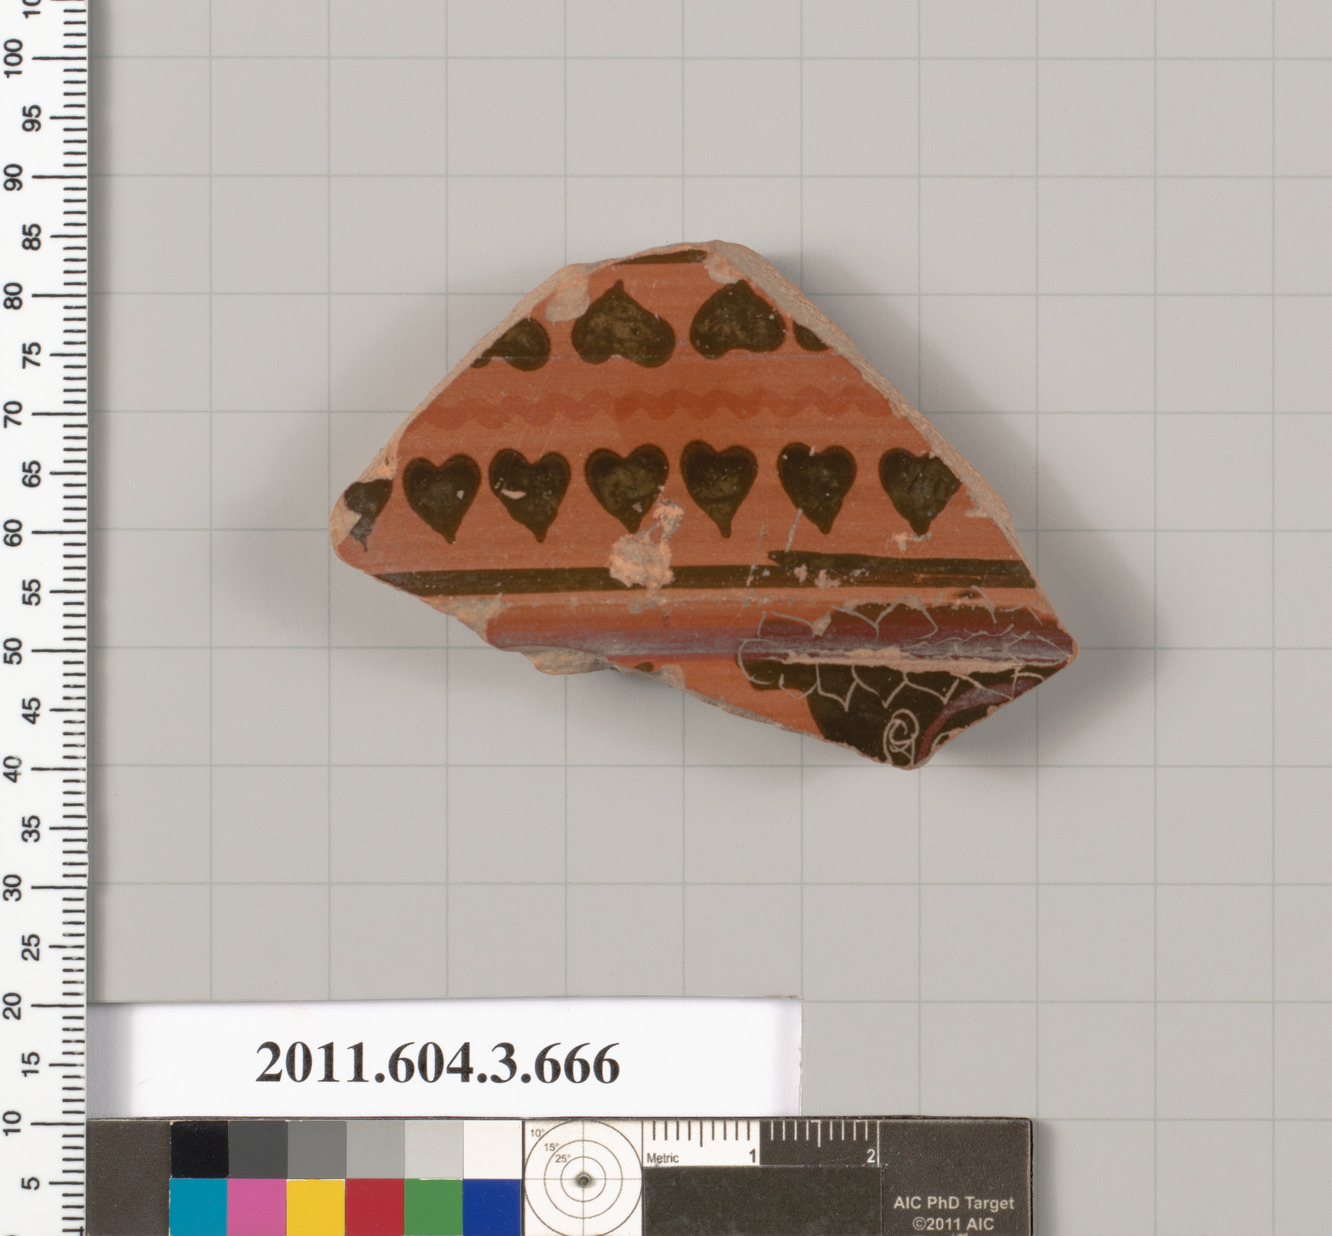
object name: calyx krater fragment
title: Terracotta fragment of a calyx-krater (bowl for mixing wine and water)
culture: greek, attic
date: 550-526 BCE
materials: terracotta